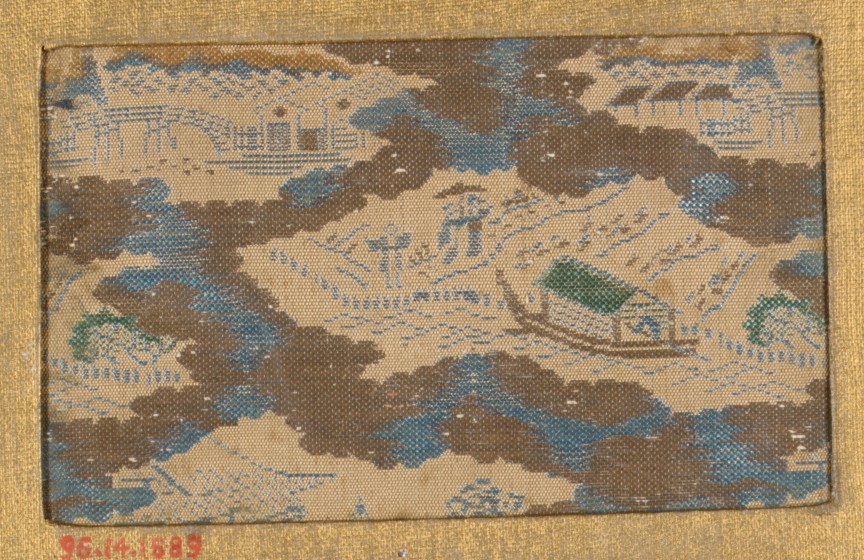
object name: piece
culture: japanese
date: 1701-1900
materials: silk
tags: human figures,bridges,boats